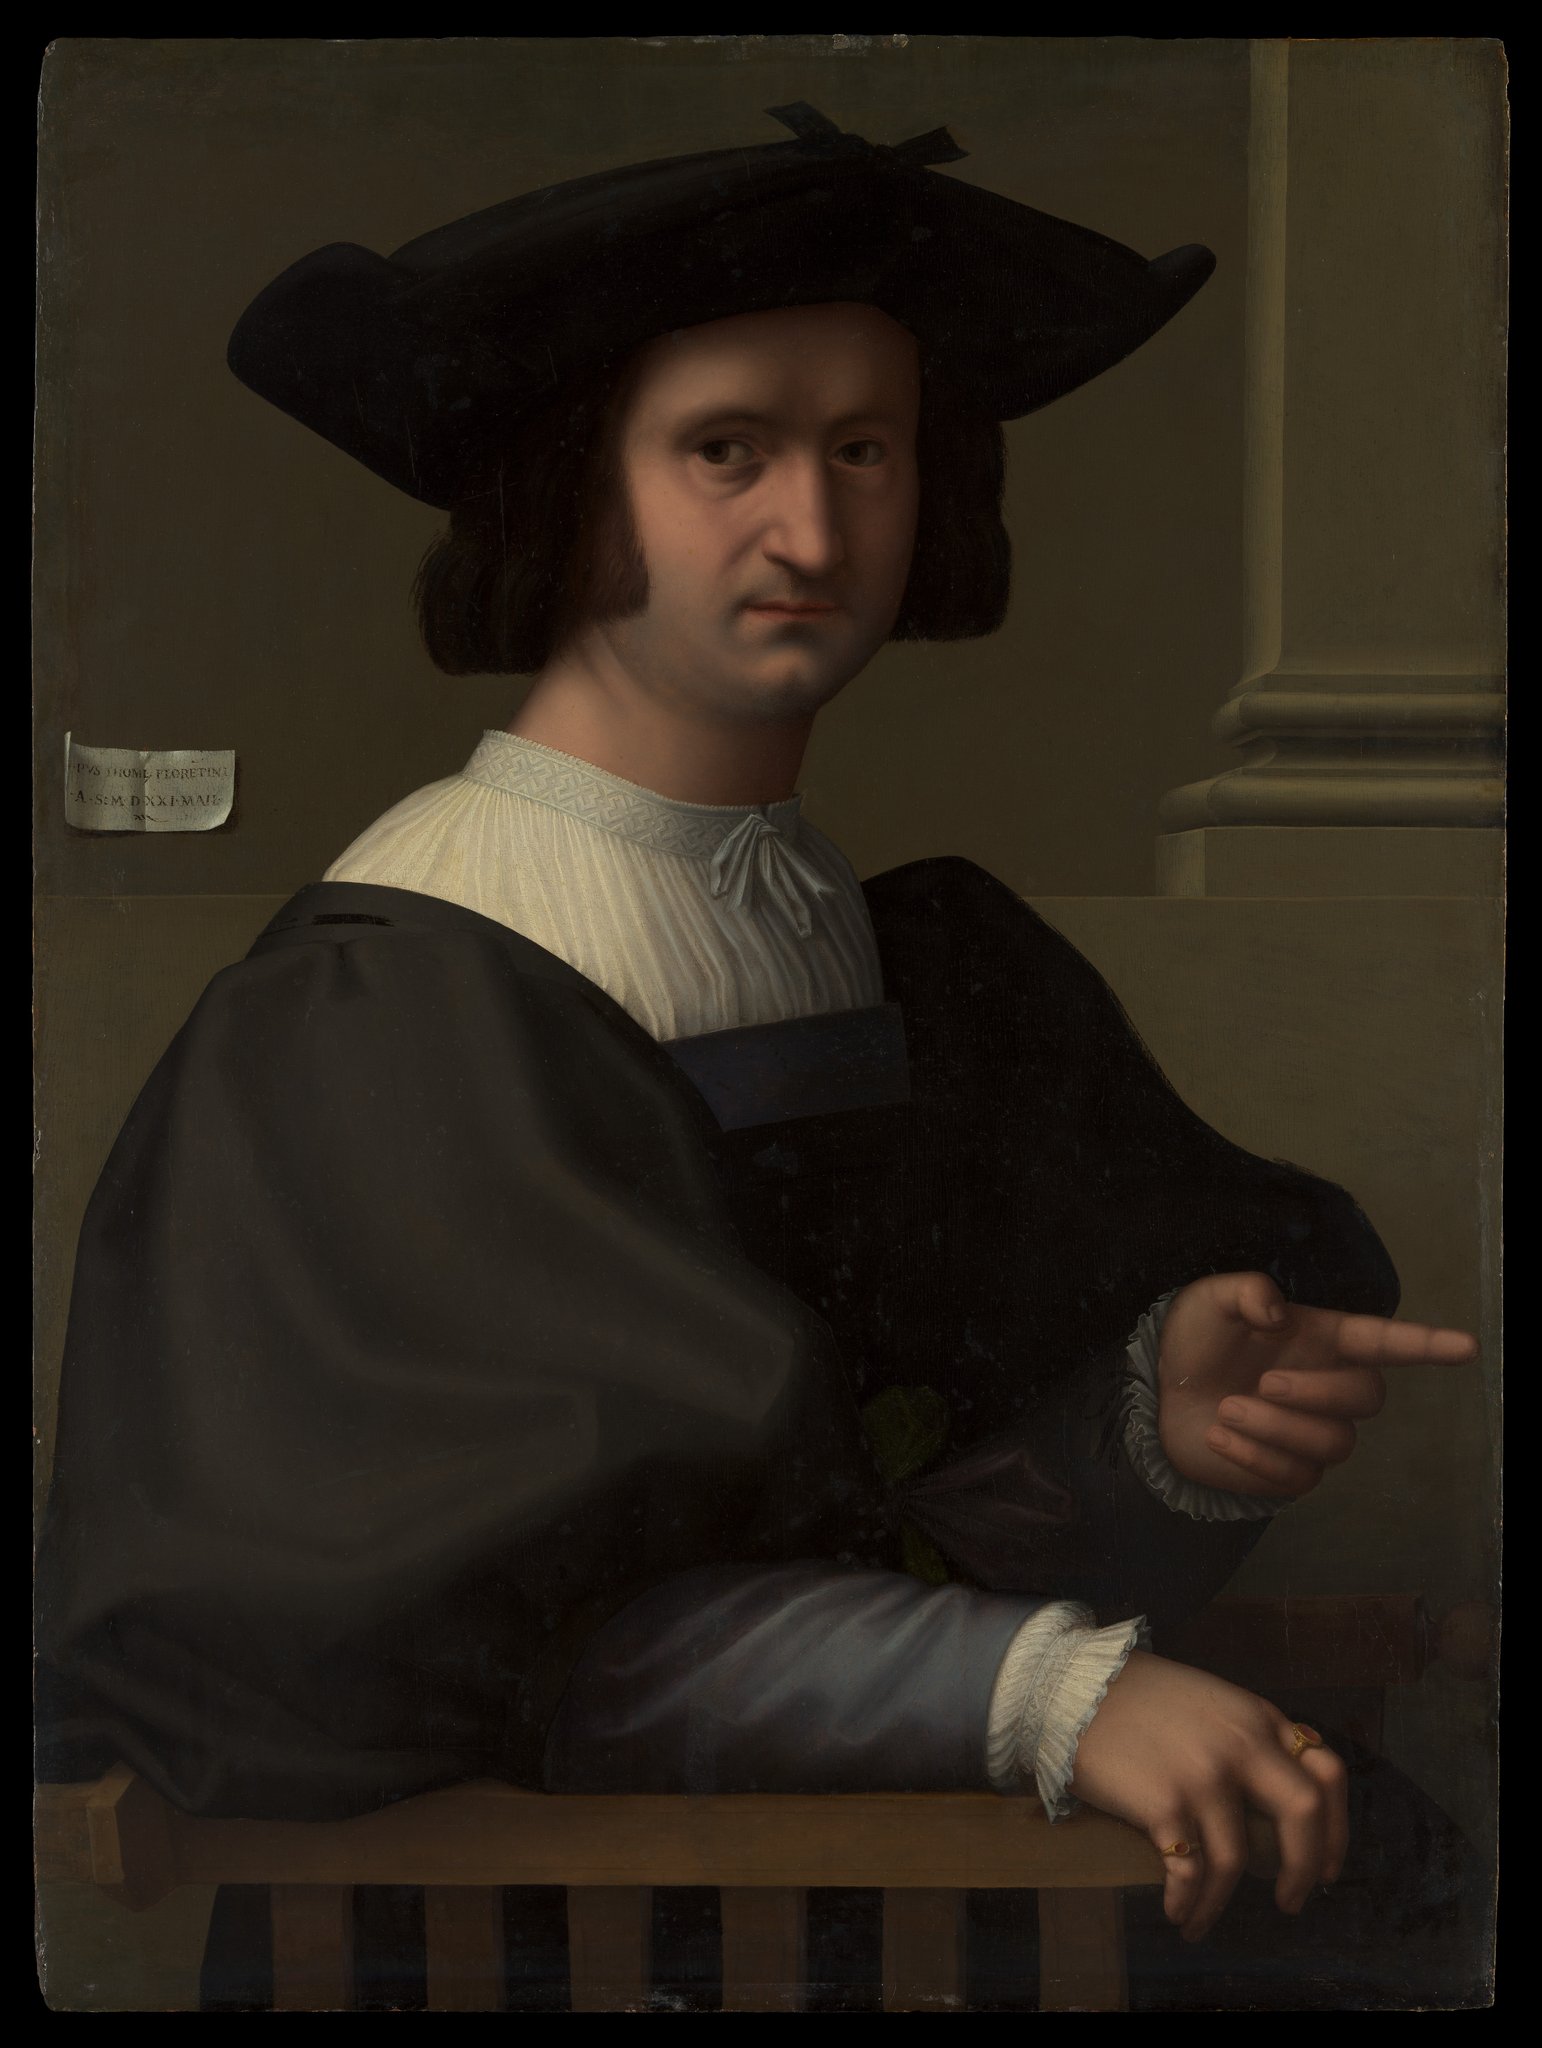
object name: painting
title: Portrait of a Man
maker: tommaso fiorentino (tommaso di stefano lunetti)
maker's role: artist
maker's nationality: italian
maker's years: 1495-1564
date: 1521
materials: oil, wood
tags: men,portraits